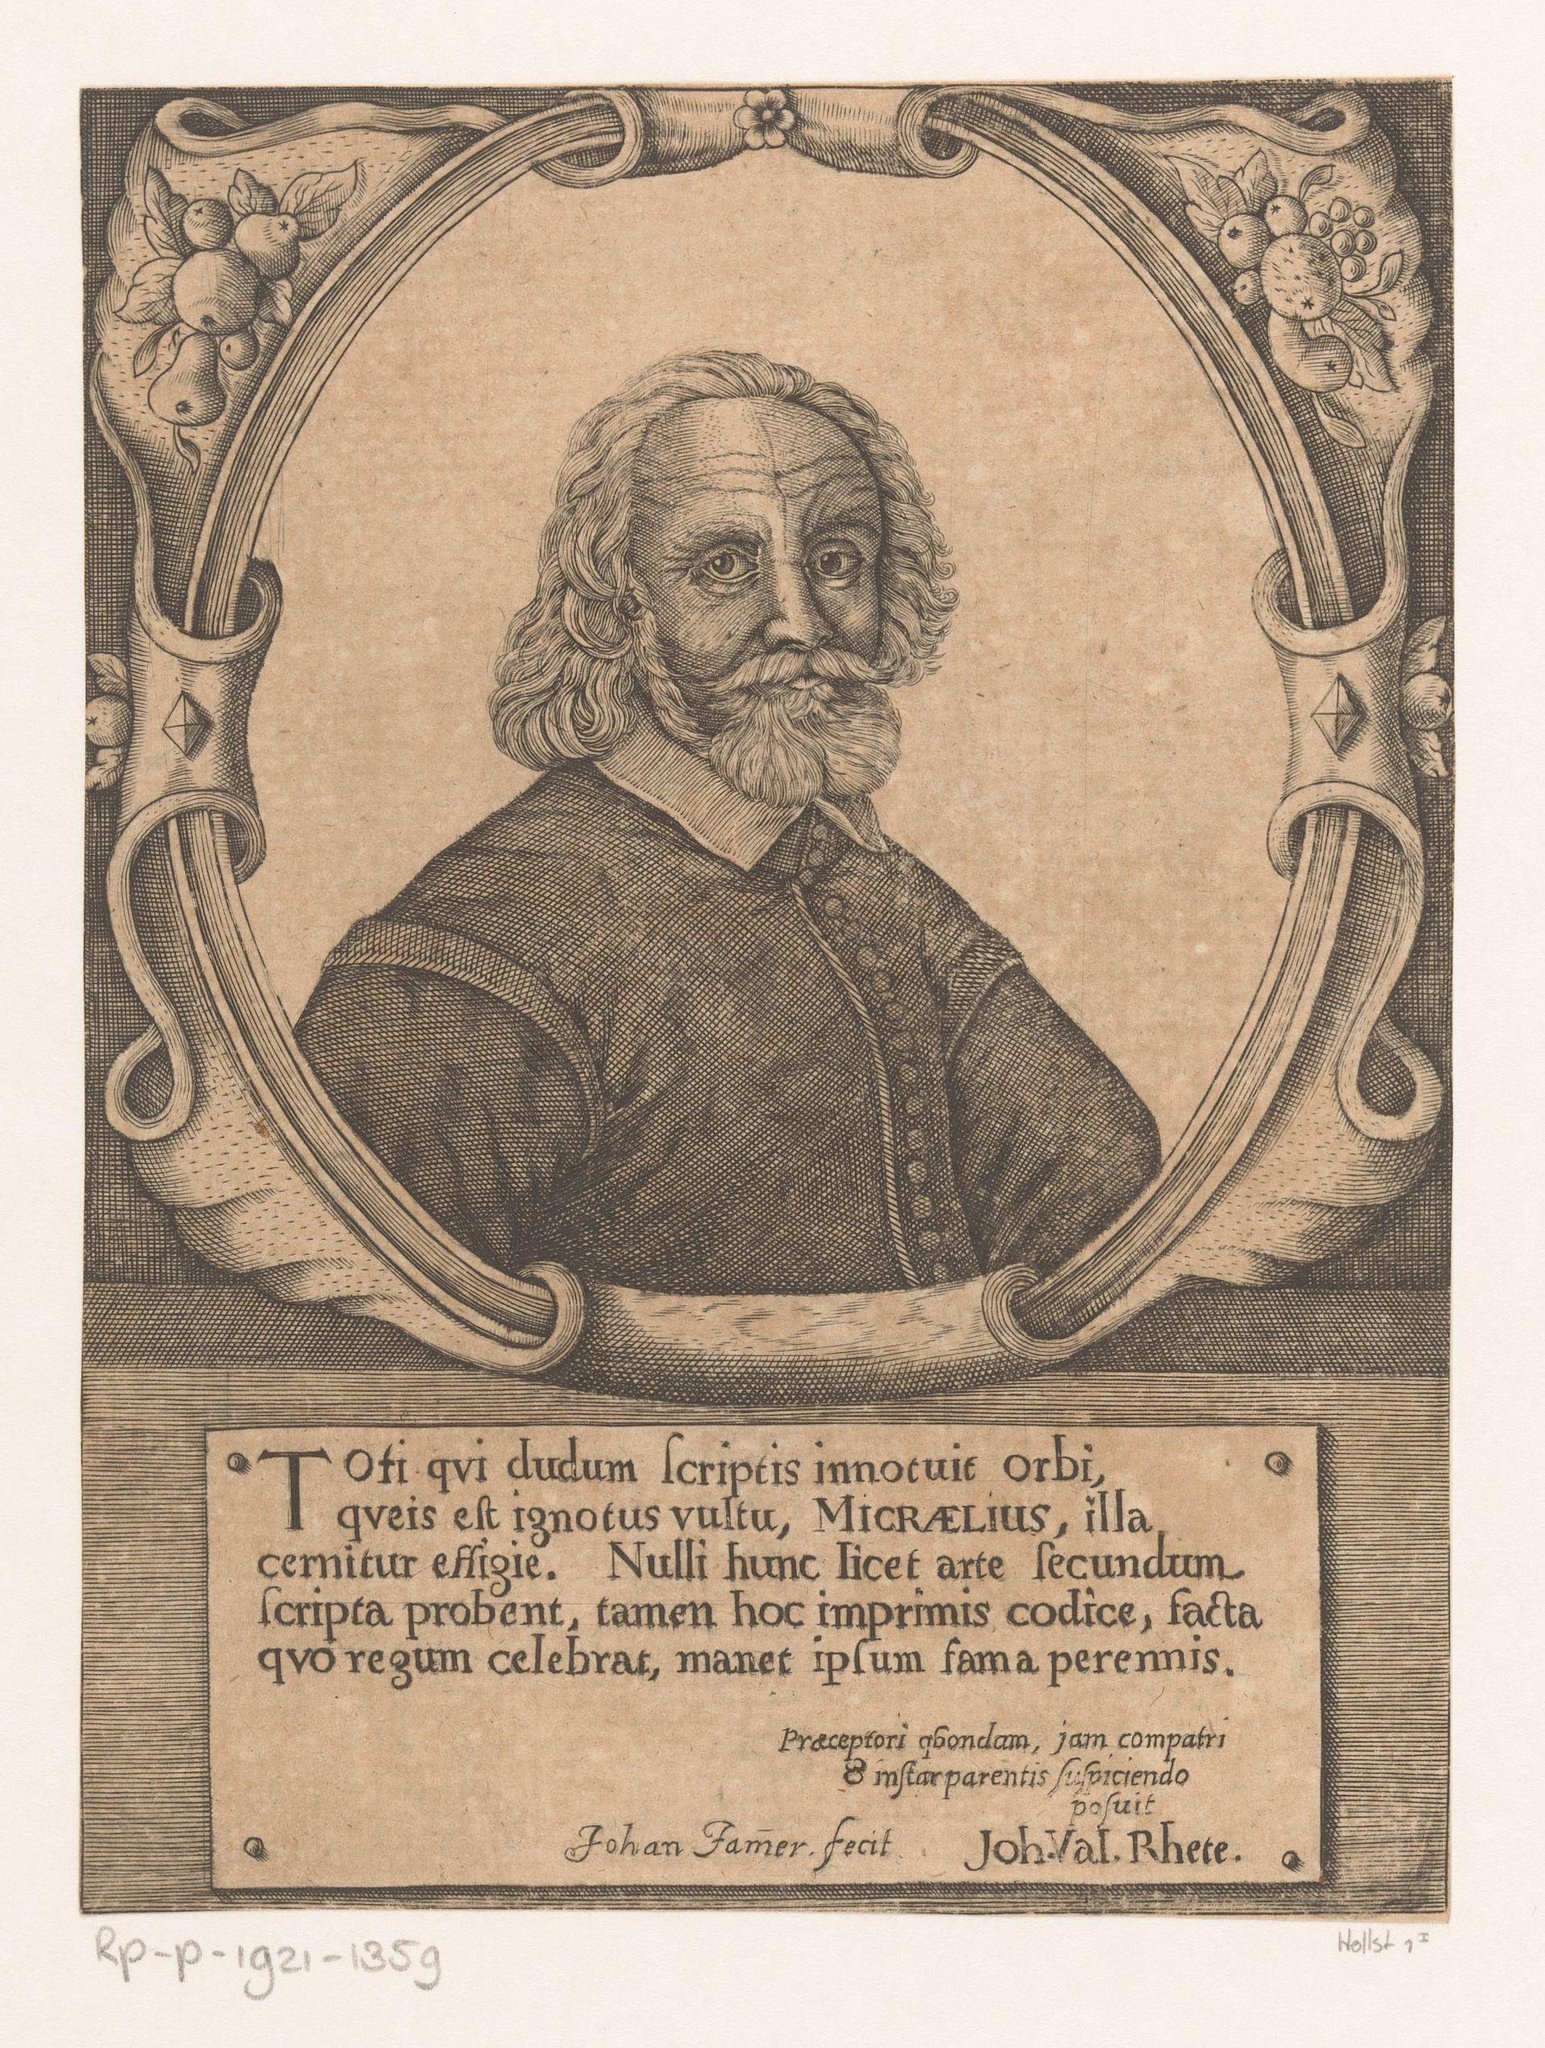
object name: print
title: Portret van Johannes Micraelius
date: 1607-1658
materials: paper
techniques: engraving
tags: historical persons, ornament ~ cartouche, fruits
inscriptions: collector's mark: Lugt 2233